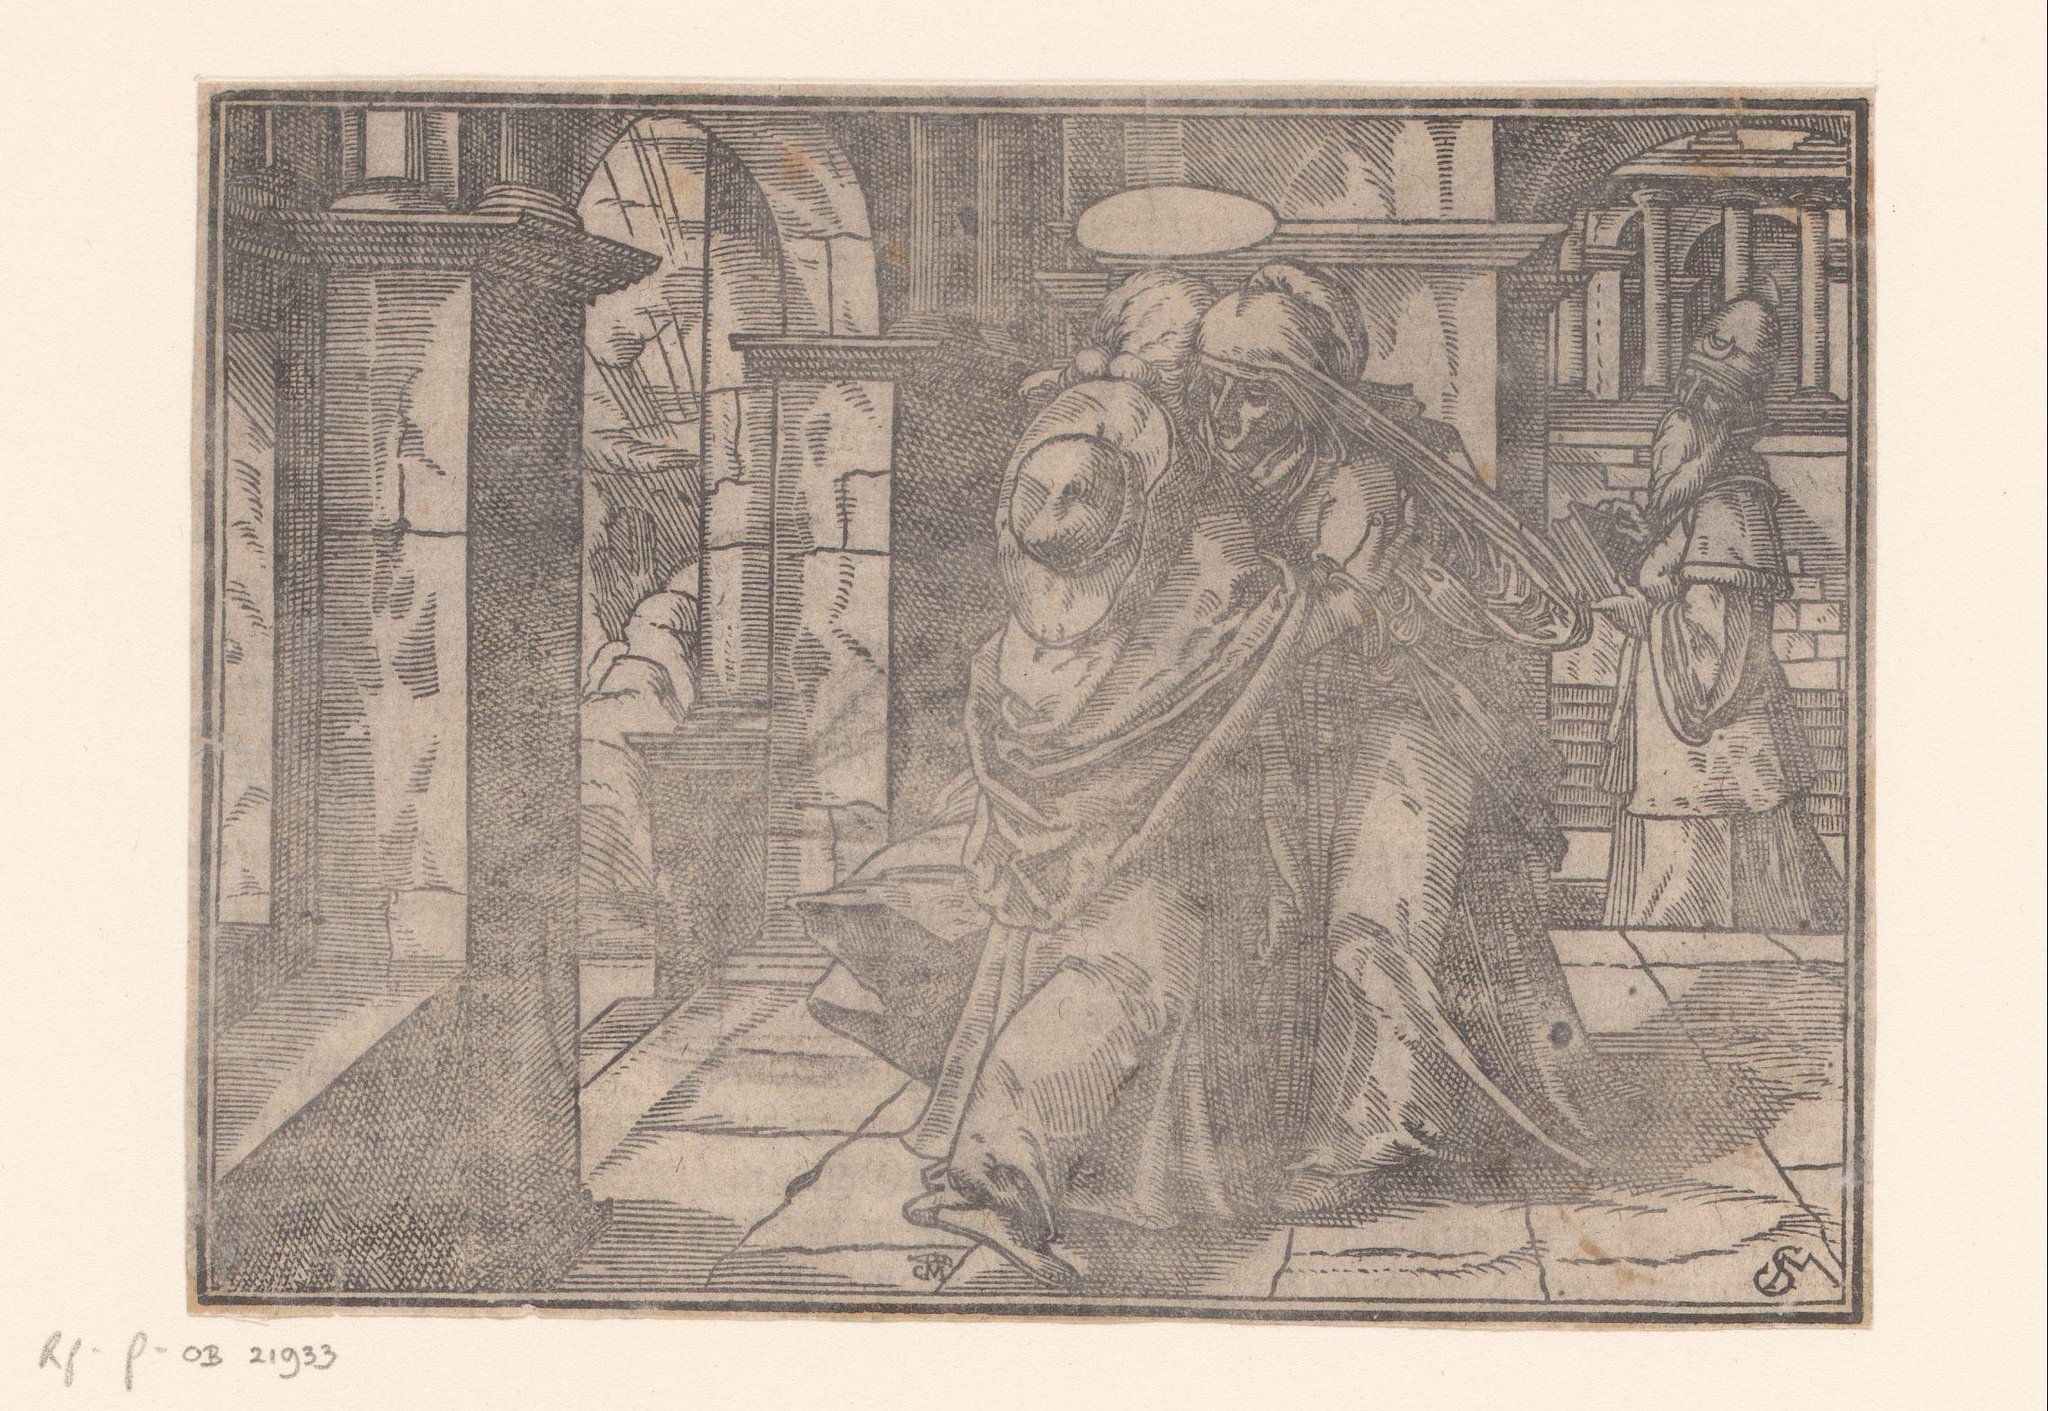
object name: print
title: Visitatie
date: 1625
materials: paper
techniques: woodcut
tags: visitation (possibly joseph and/or zacharias present) (luke 1:39-56)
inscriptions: collector's mark: Lugt 240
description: Prent mogelijk afkomstig uit: Novae Sacrorum Bibliorum Figurae (...). Straatsburg: Christoph von der Heyden, 1625.